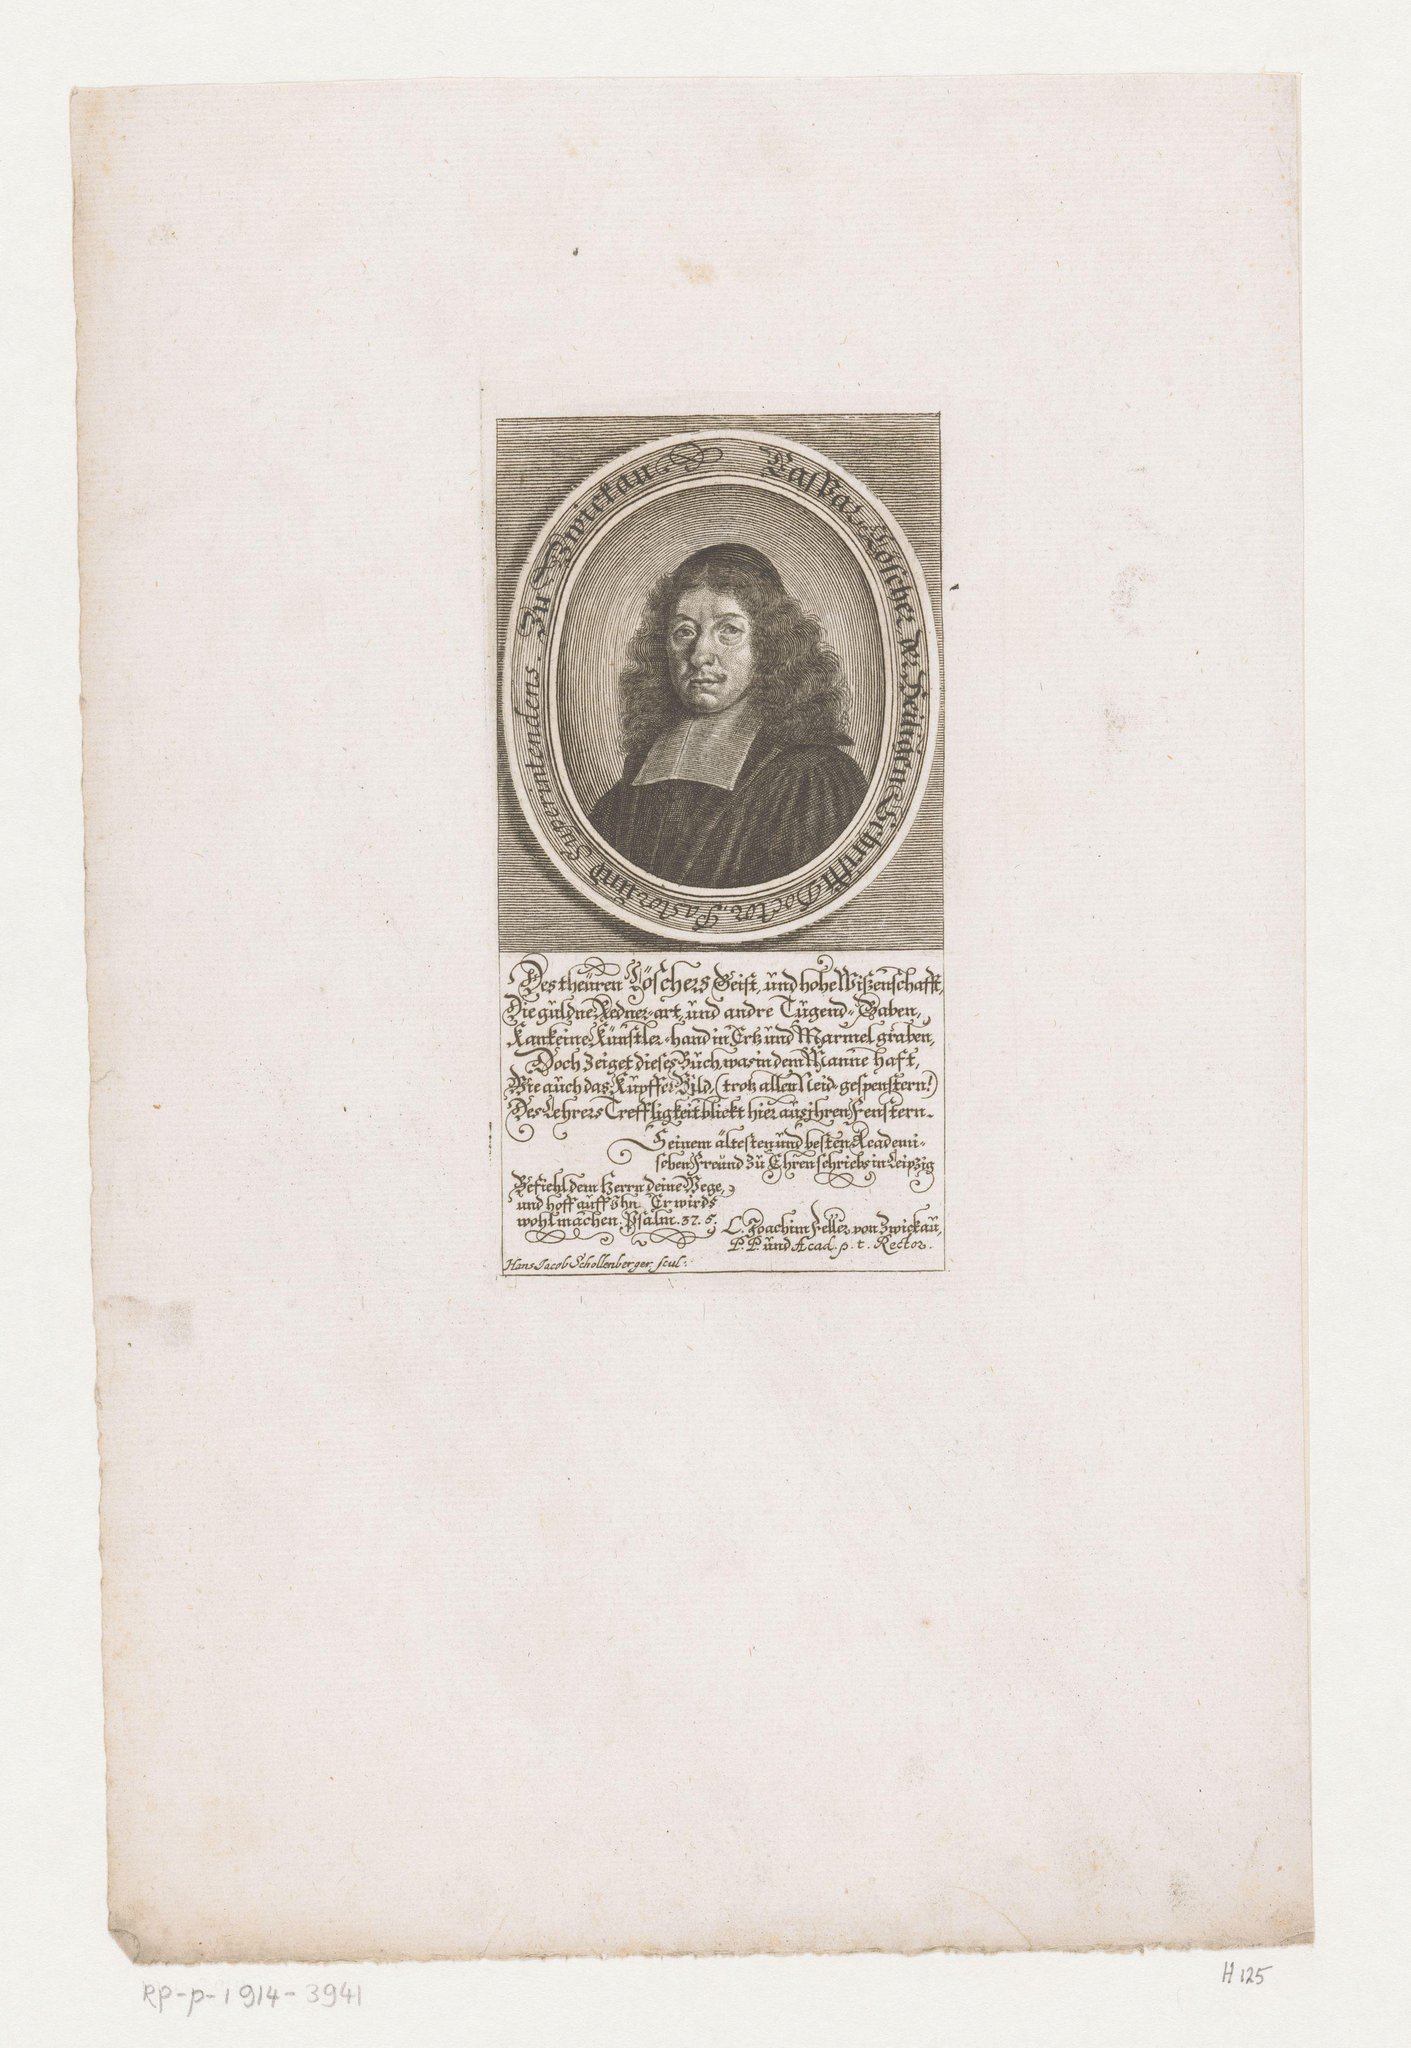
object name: print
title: Portret van Caspar Löscher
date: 1681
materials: paper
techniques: engraving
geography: zwickau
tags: theologian, further education (+ portrait of teacher, professor), historical persons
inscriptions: collector's mark: Lugt 2228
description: Prent ook gebruikt in: Löscher, Caspar. Der durch die Liebe thätige Glaube. Zwickau: Johann Leonhard, 1681.